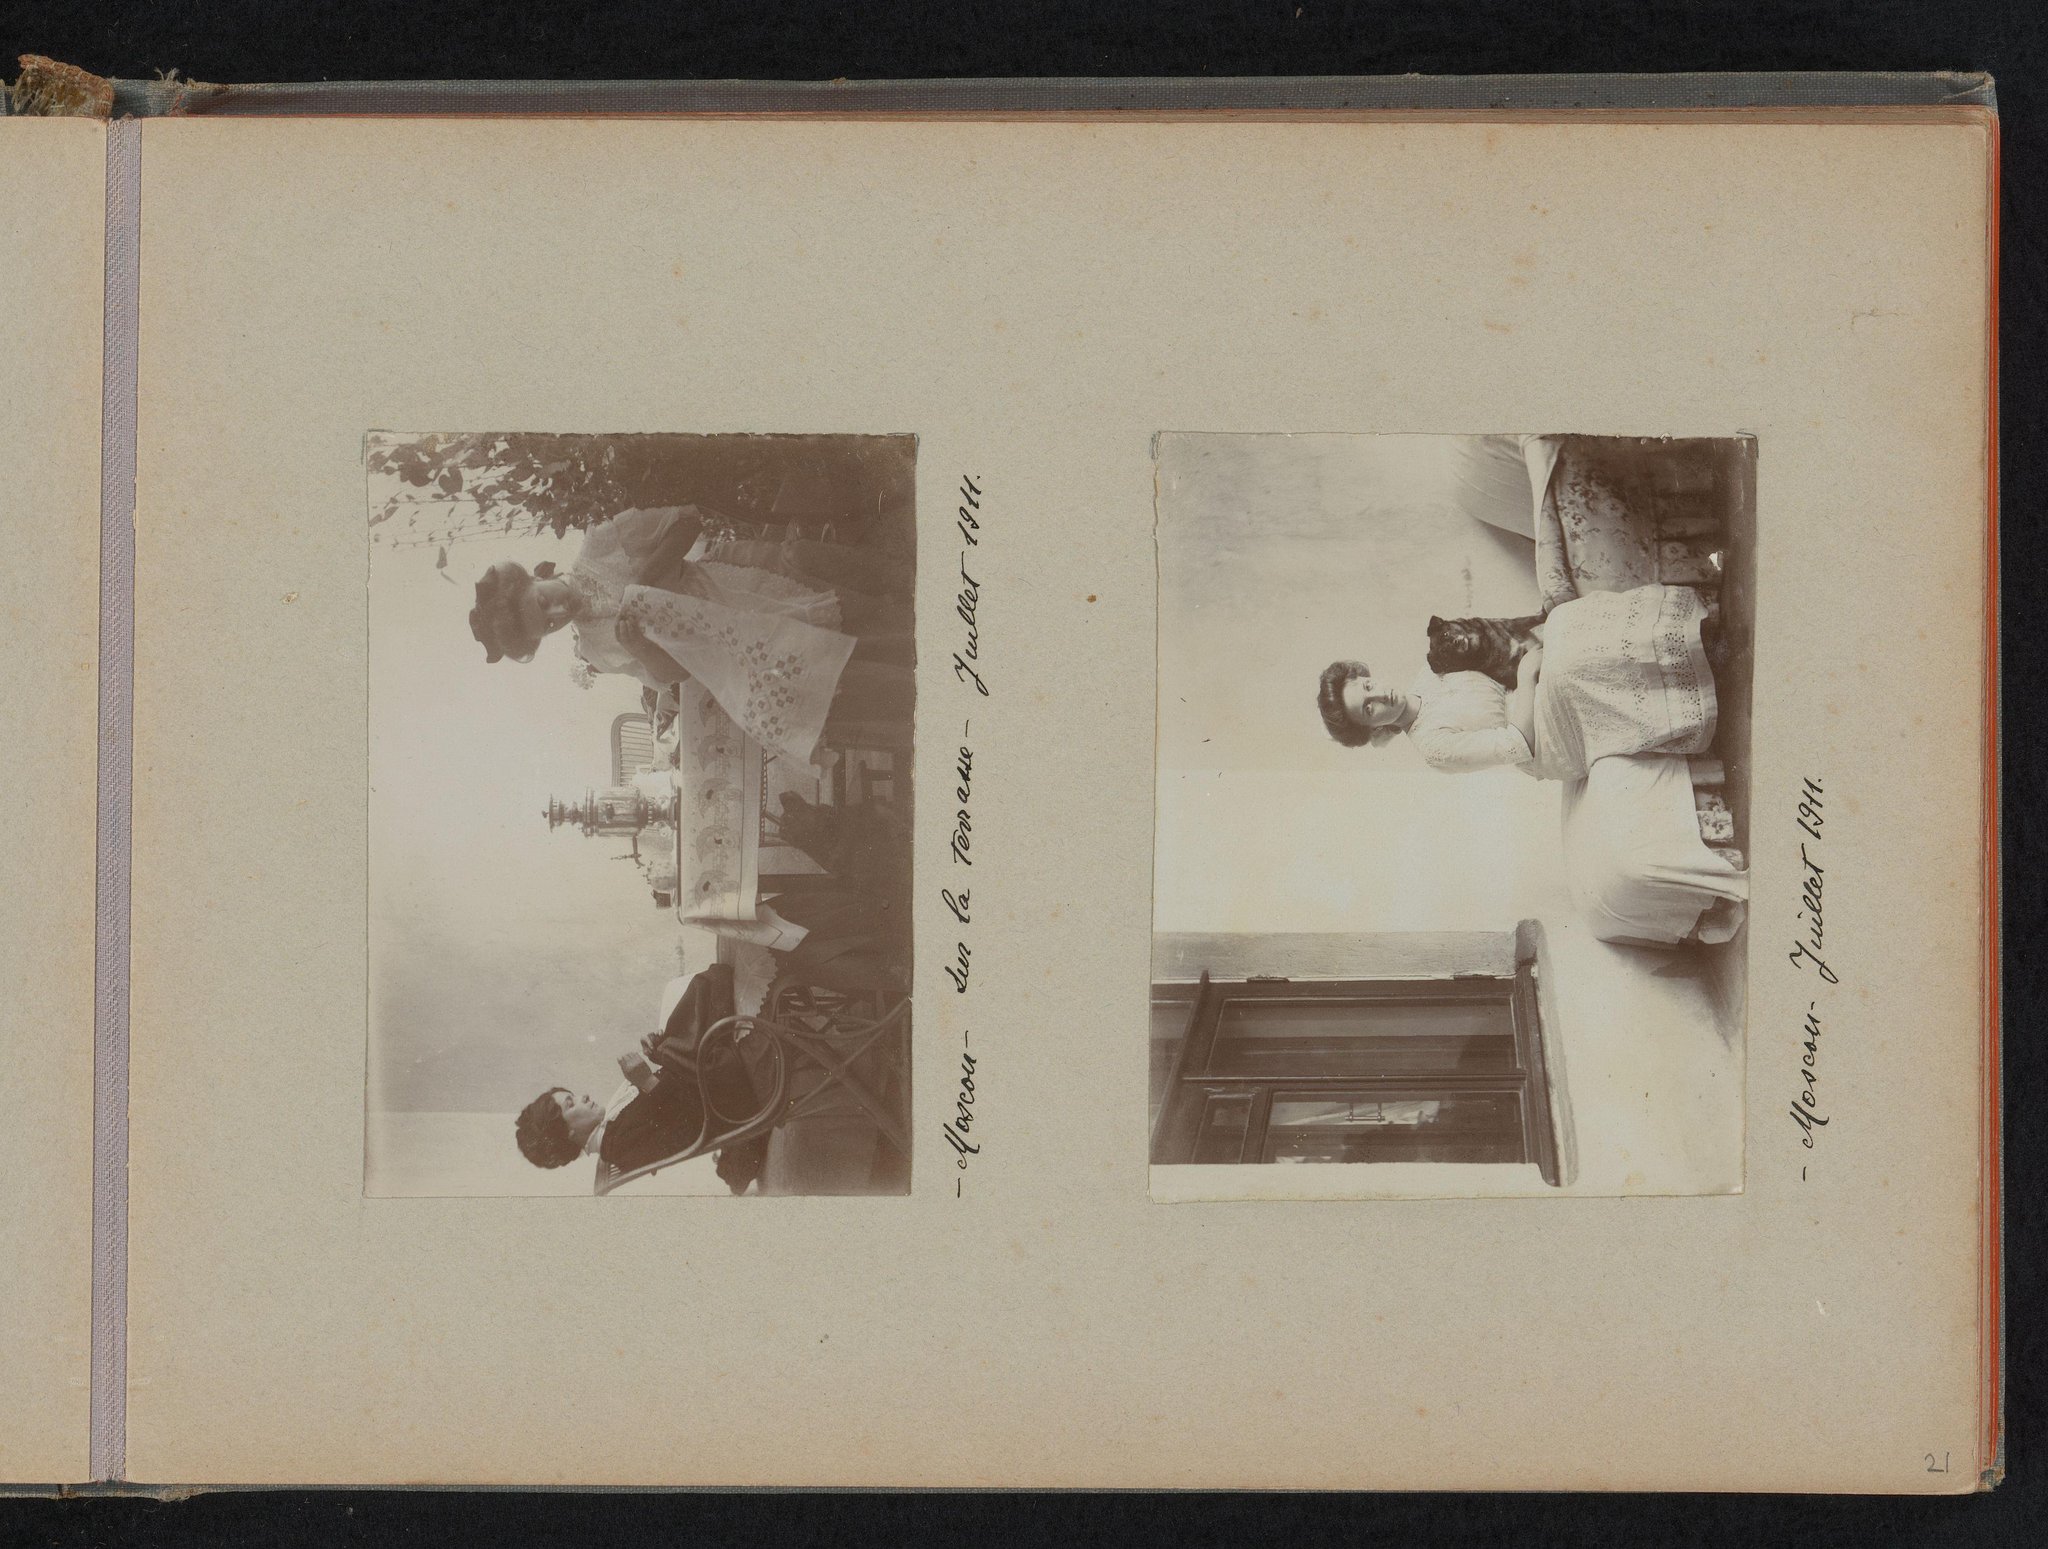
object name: photograph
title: Twee bordurende vrouwen op een terras en een vrouw met hond op een bank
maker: Anonymous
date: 1907-1911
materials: paper, cardboard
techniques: collodion silver print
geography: moscow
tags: historical persons - bb - woman, terrace, dog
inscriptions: inscription: ‘- Moscou - Juillet 1911.’, inscription: ‘- Moscou - sur la terrasse - Juillet 1911.’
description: Deze foto's maken deel uit van een album.